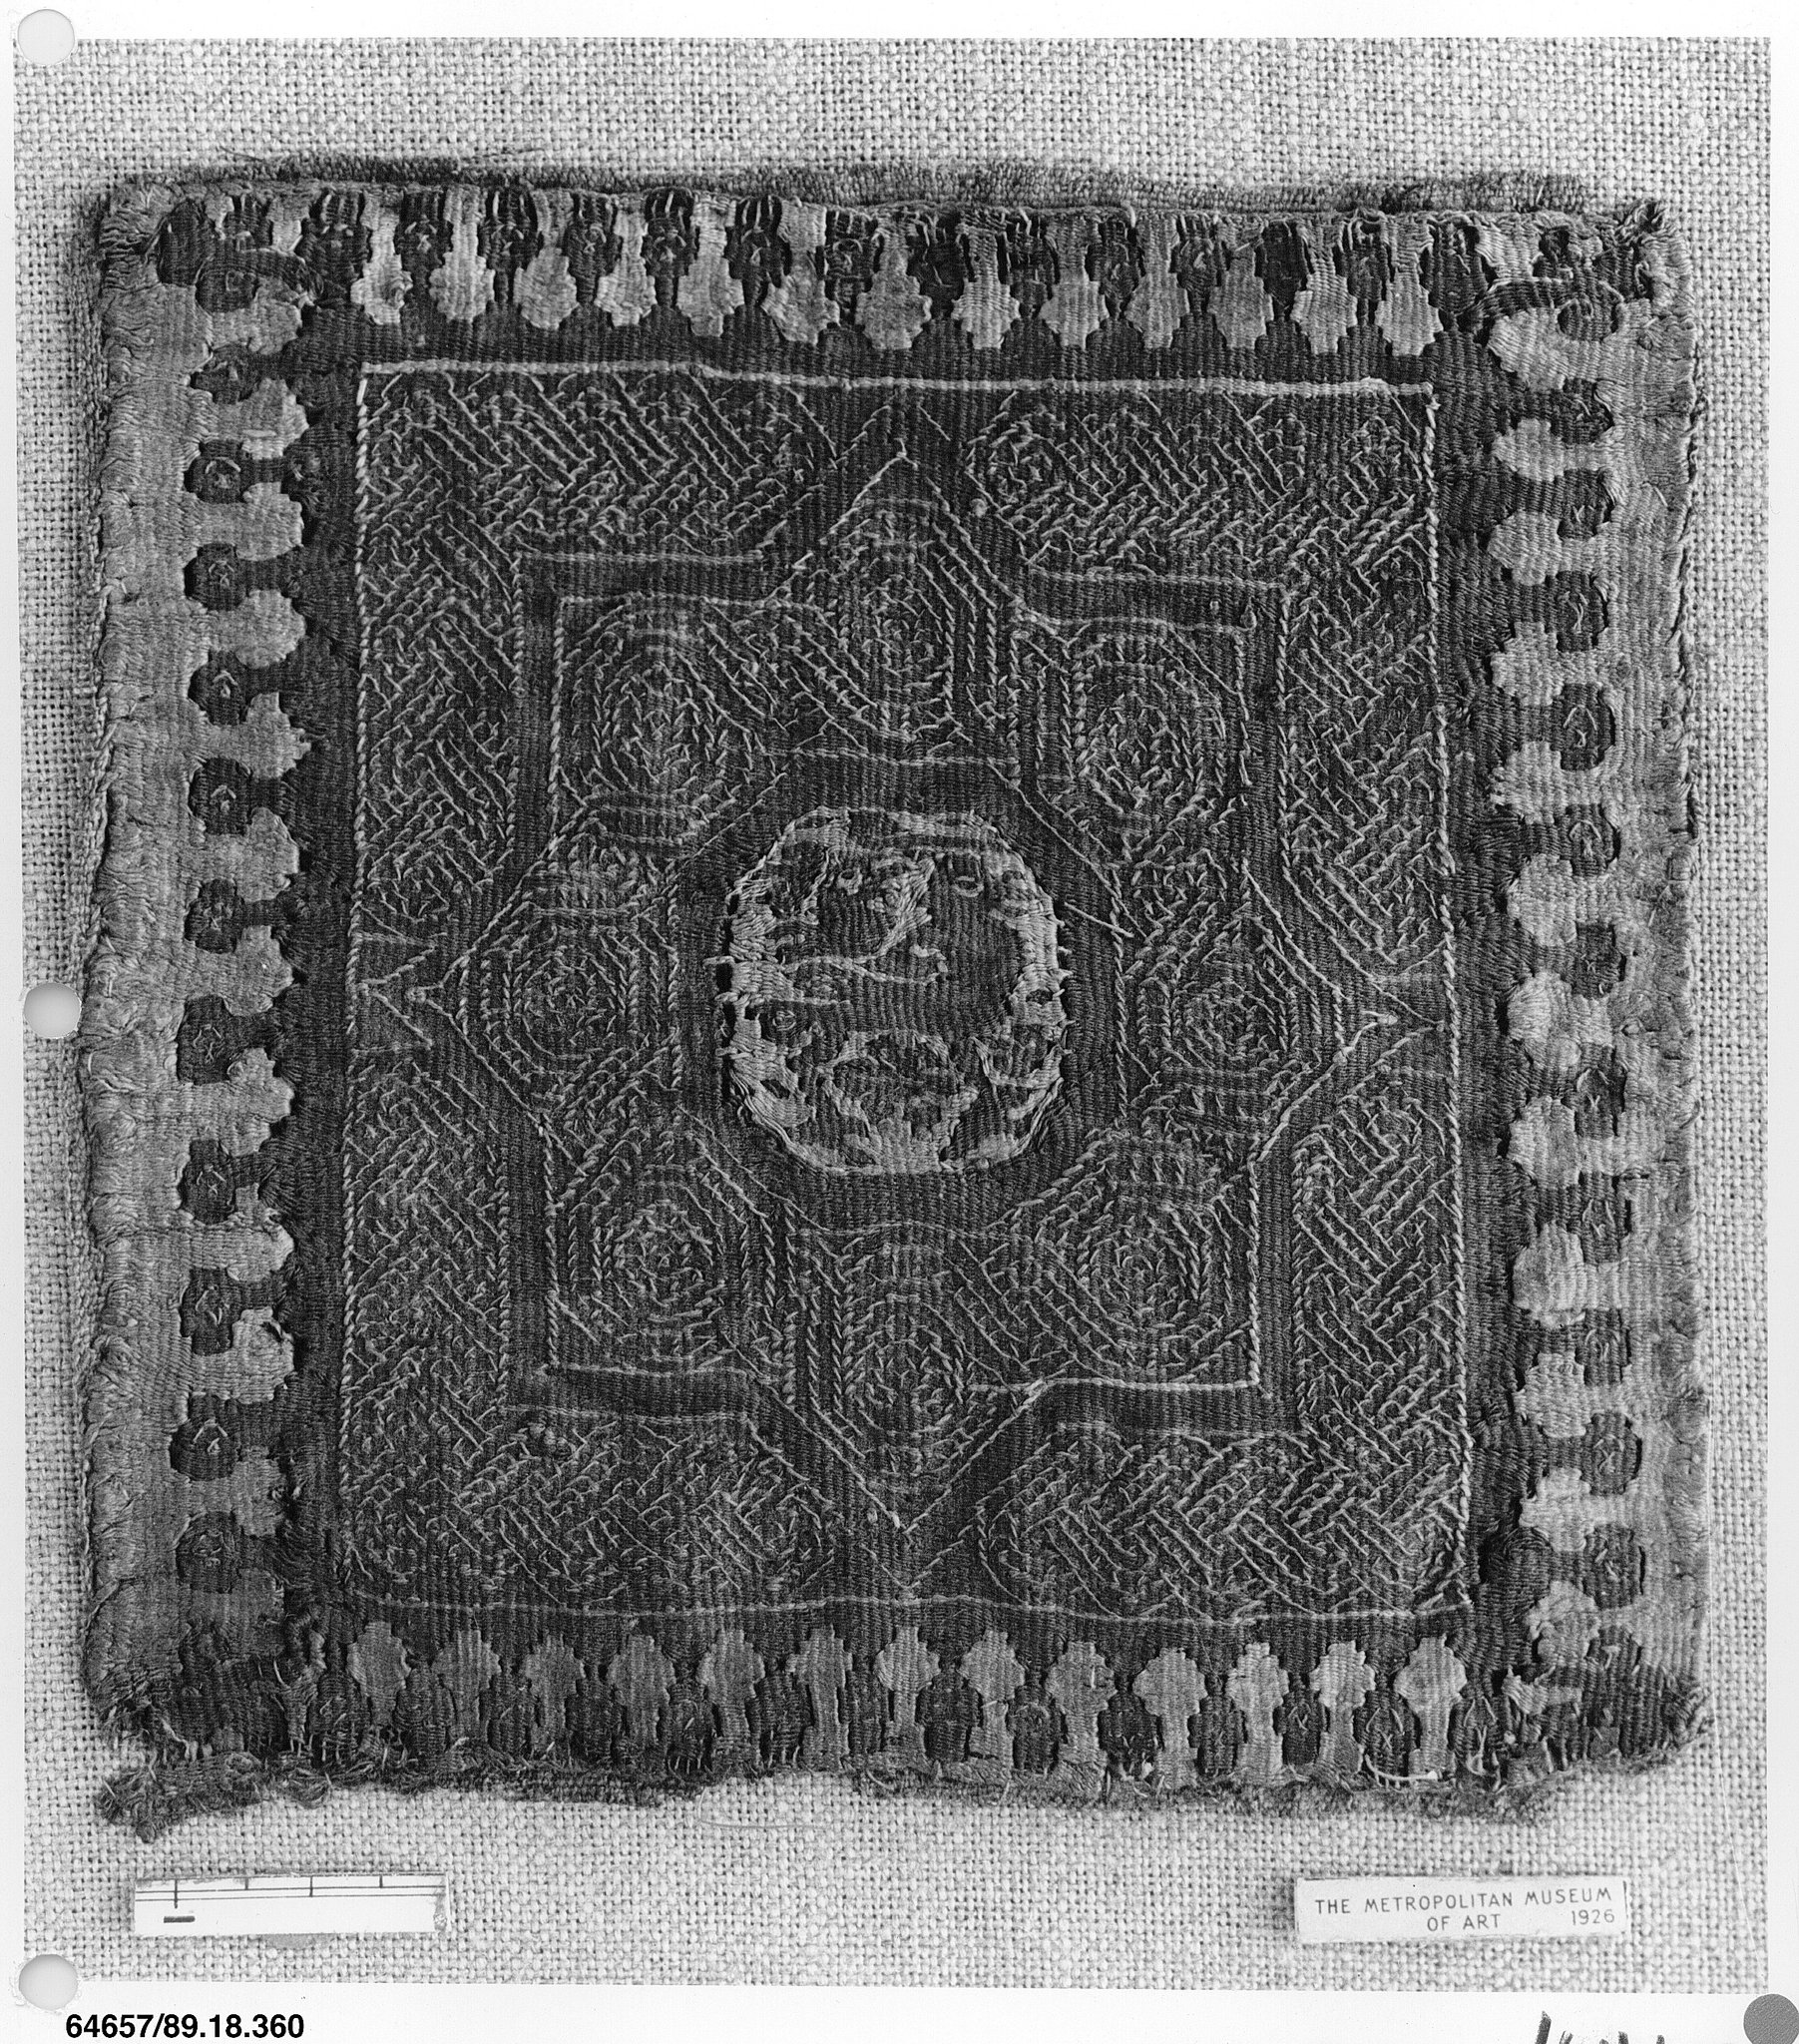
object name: textile fragment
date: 301-400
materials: linen, wool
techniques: weave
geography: egypt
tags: birds